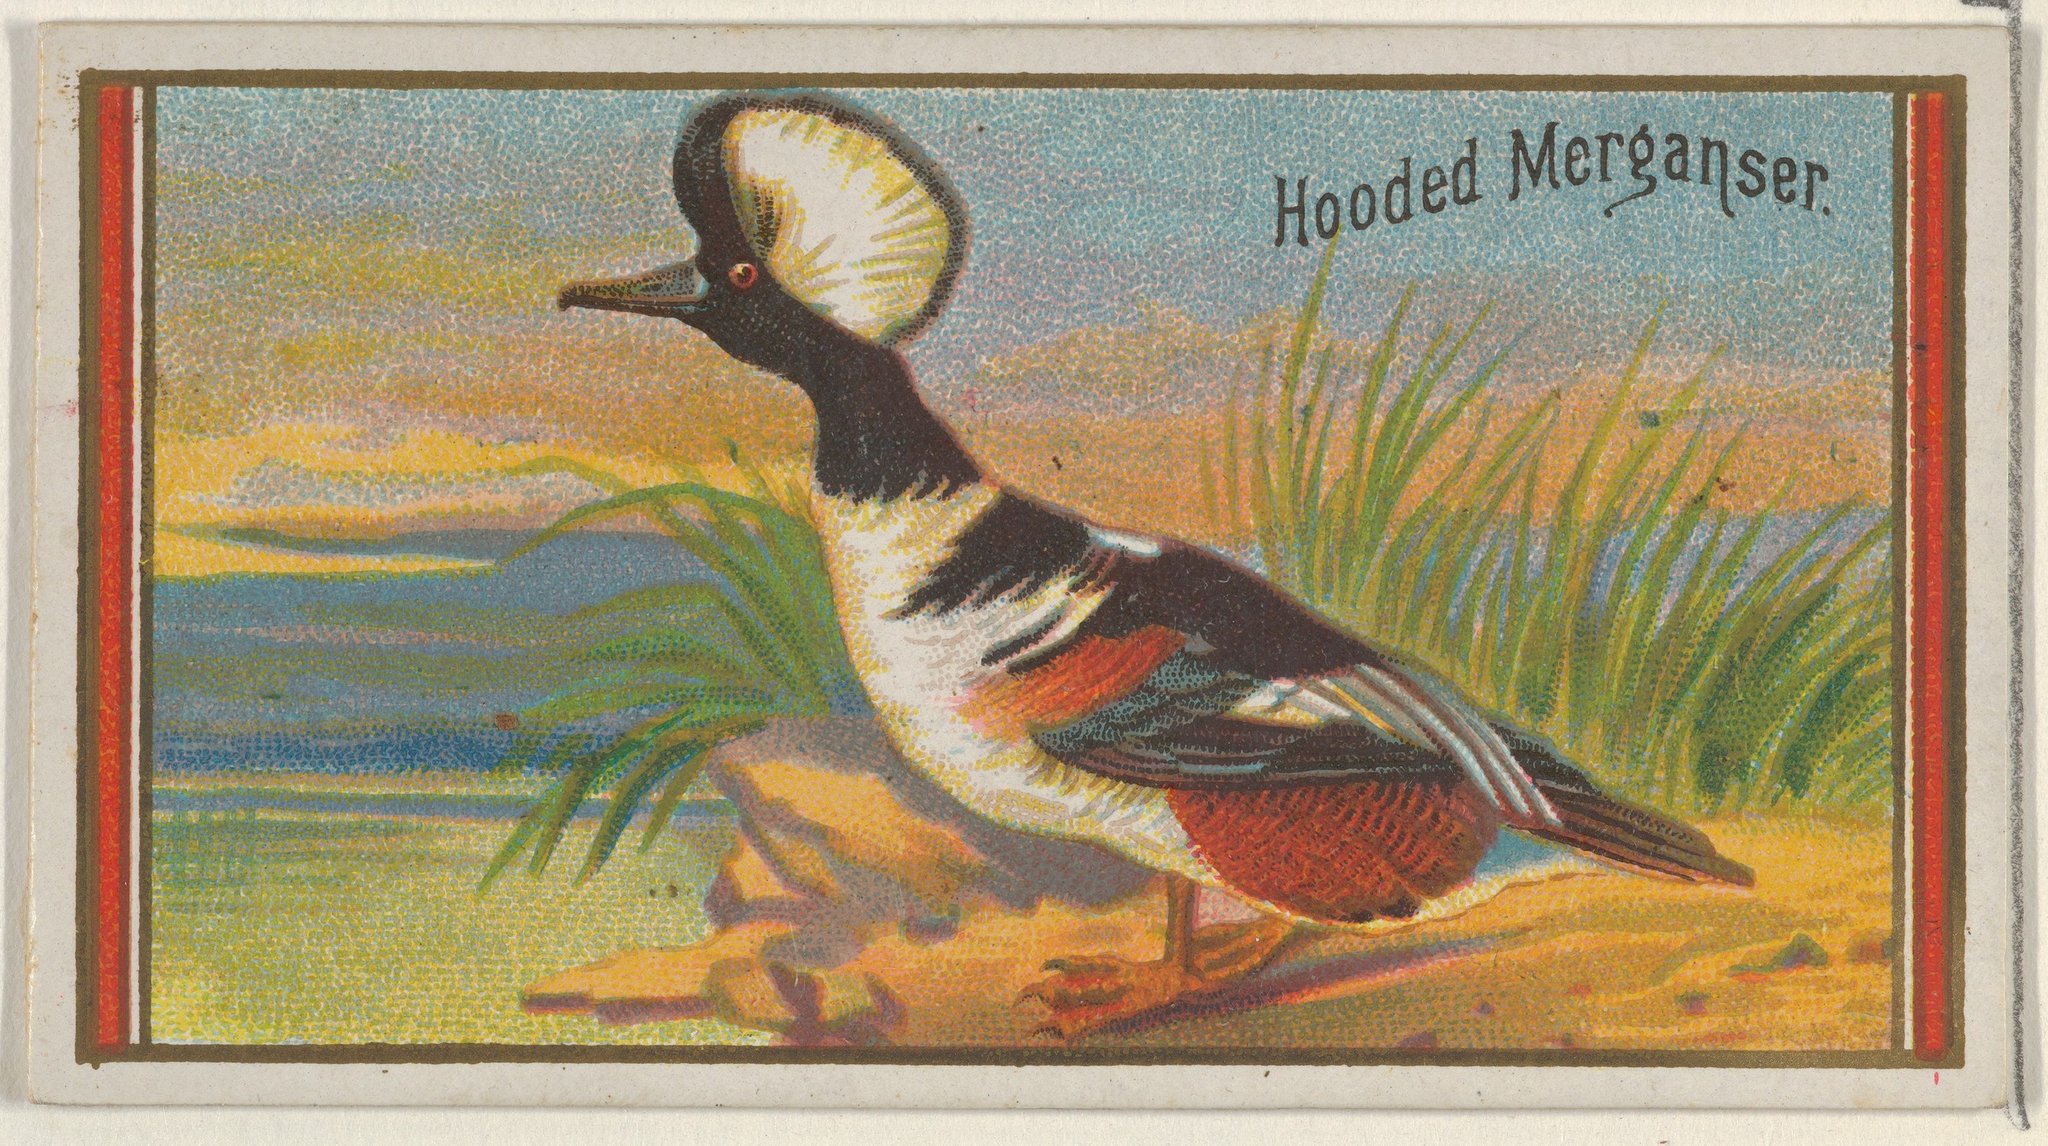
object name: print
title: Hooded Merganser, from the Game Birds series (N13) for Allen & Ginter Cigarettes Brands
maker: allen & ginter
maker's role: publisher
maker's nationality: american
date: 1889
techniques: color lithograph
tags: birds